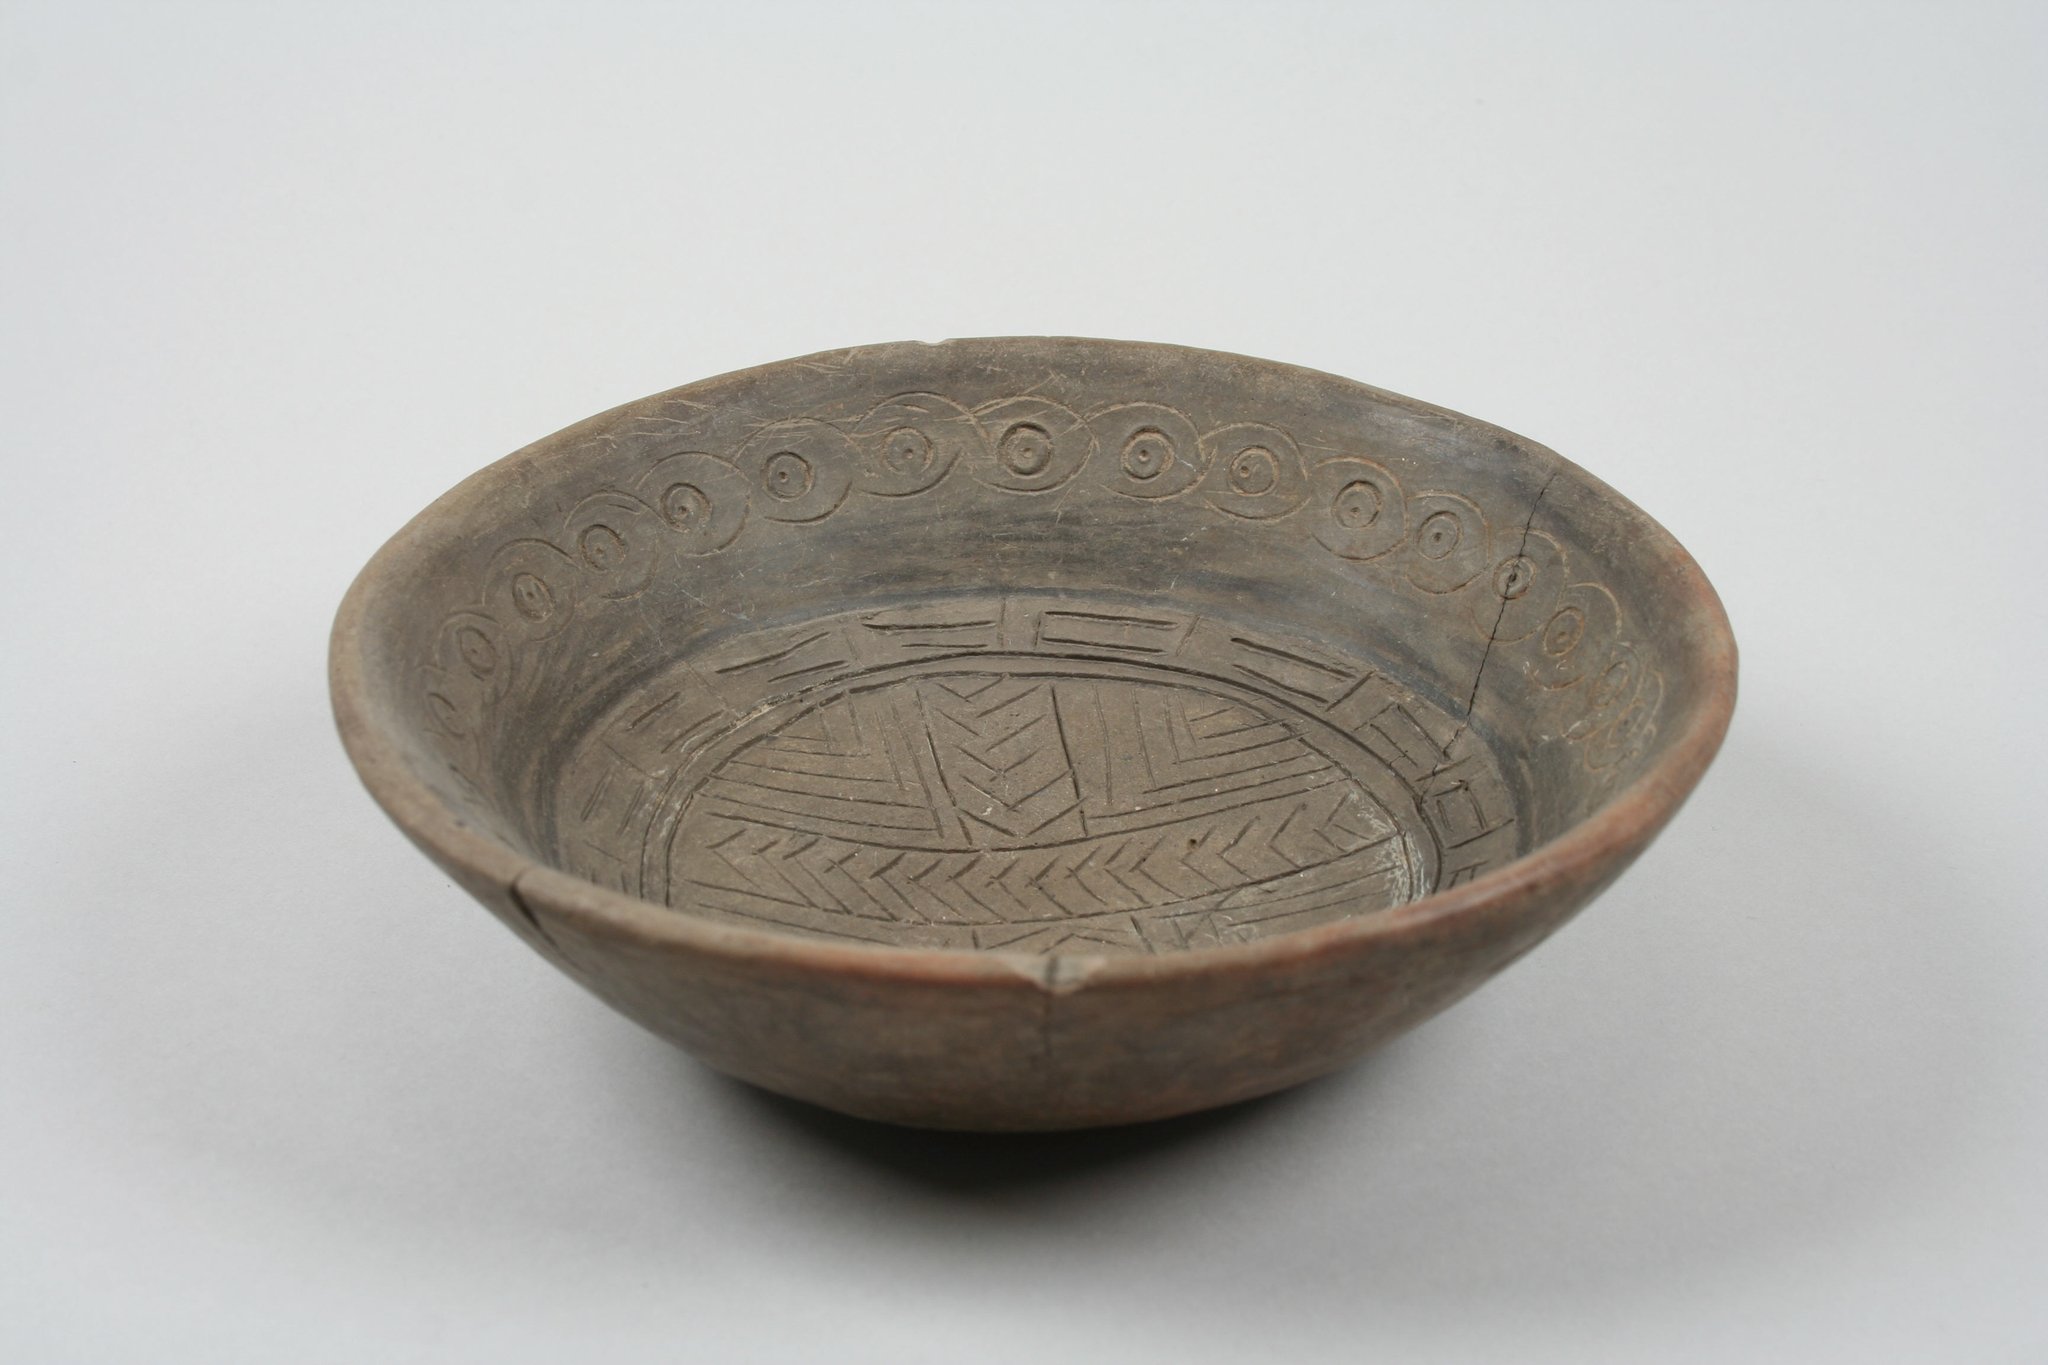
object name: bowl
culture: paracas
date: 700-301 BCE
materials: ceramic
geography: peru